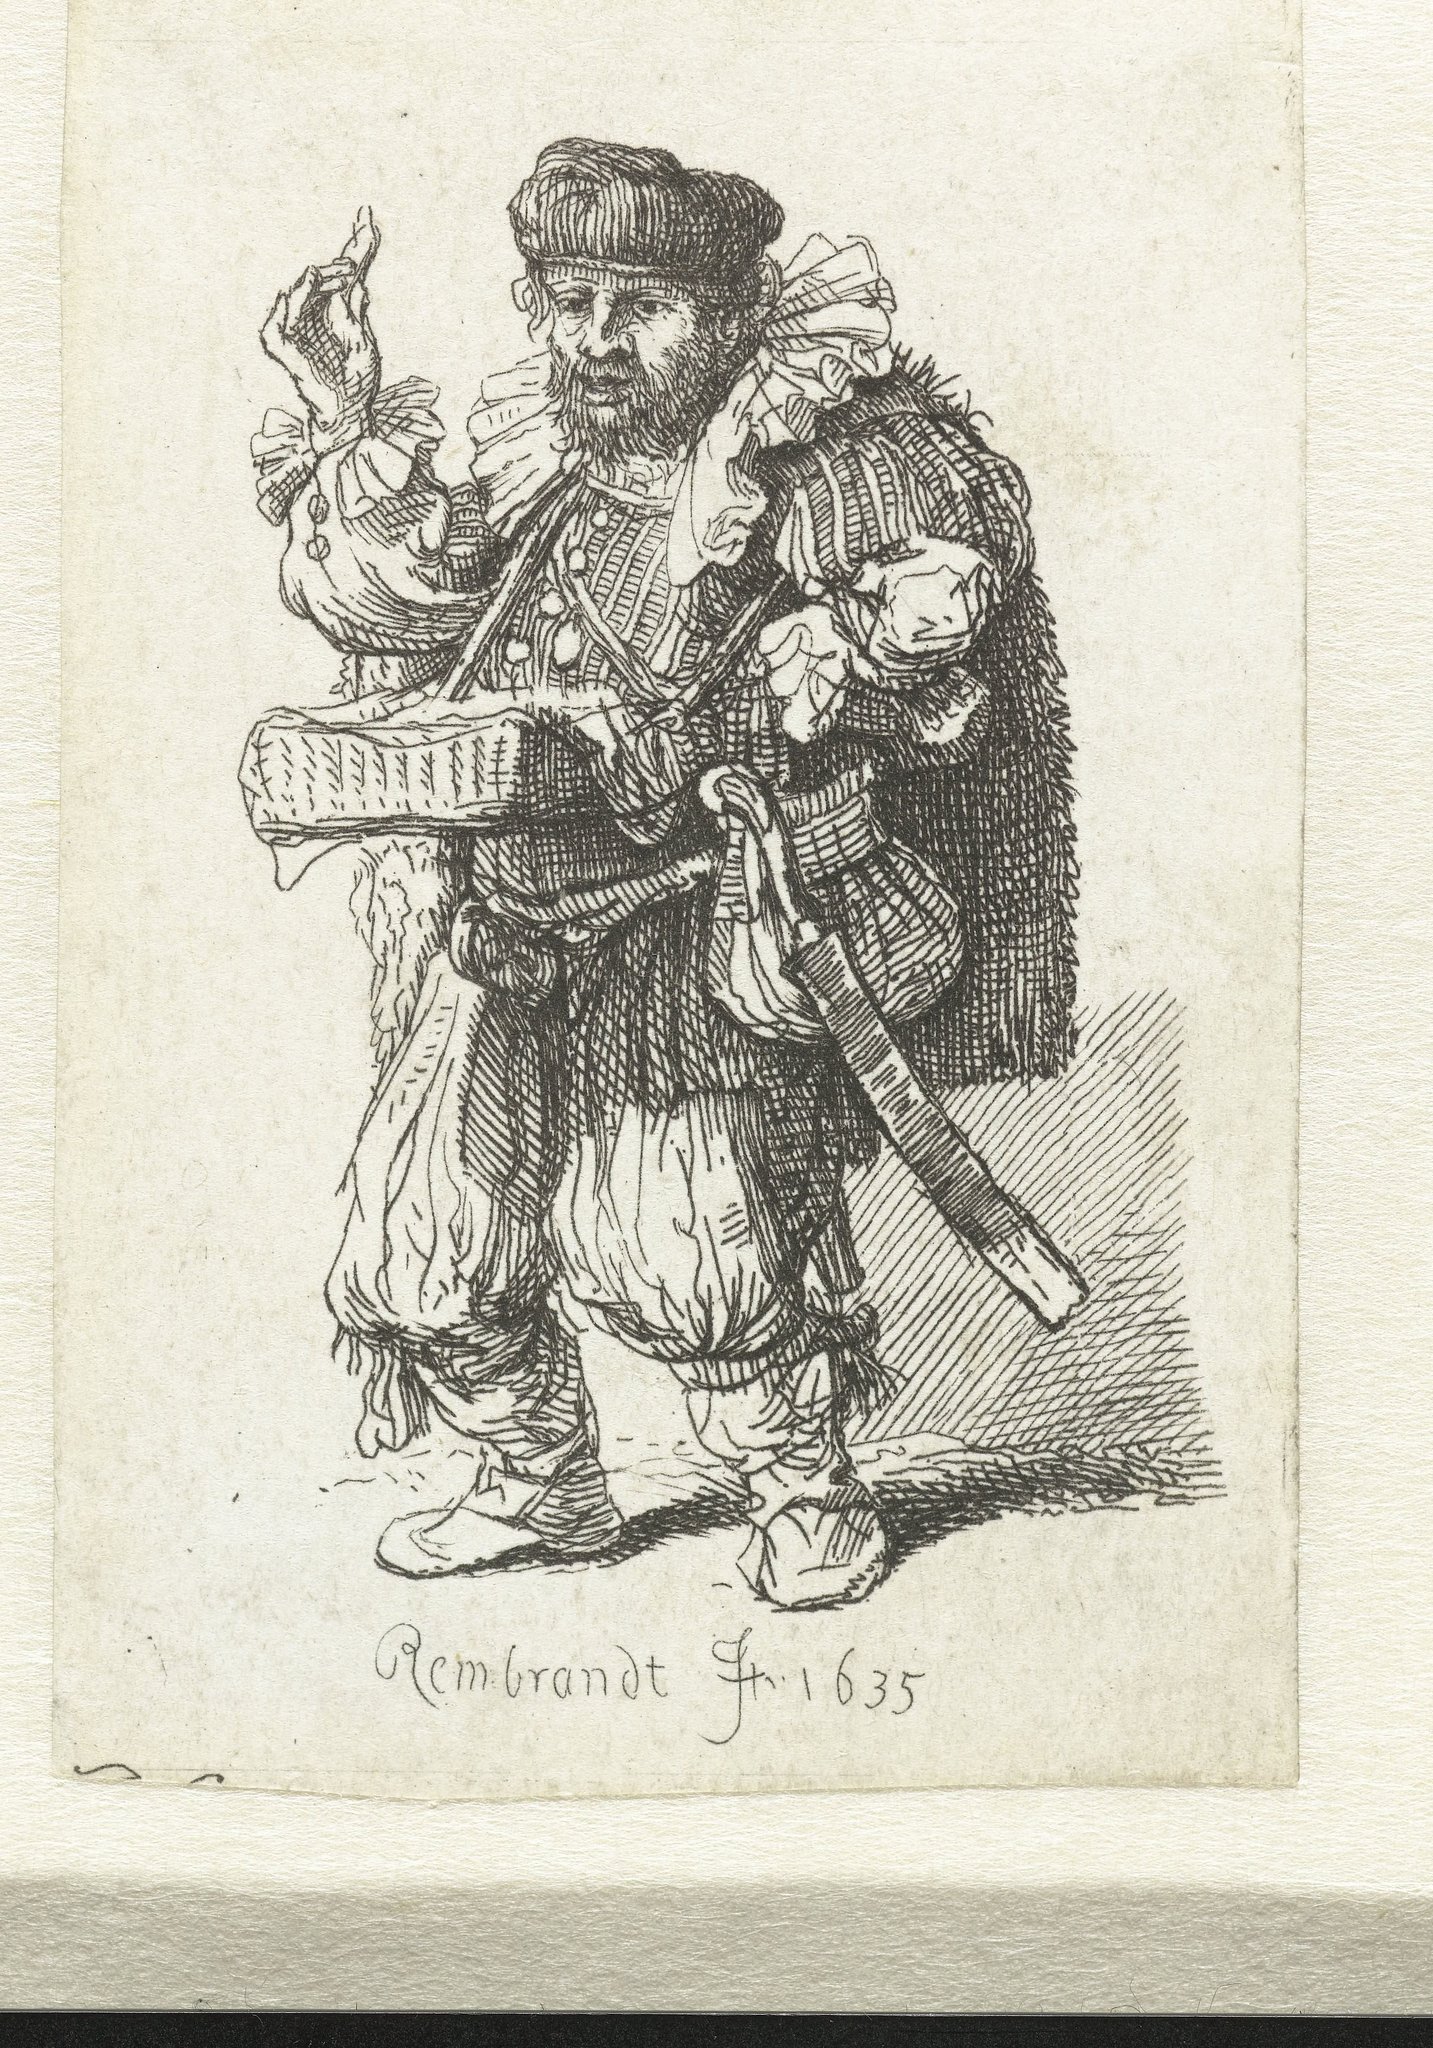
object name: print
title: The quacksalver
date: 1719-1780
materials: paper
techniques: etching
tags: quack, charlatan, mountebank, 'saltimbanco'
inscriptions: collector's mark: Lugt 2760, collector's mark: Lugt 2228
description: Spiegelbeeldige kopie naar de gelijknamige prent van Rembrandt.